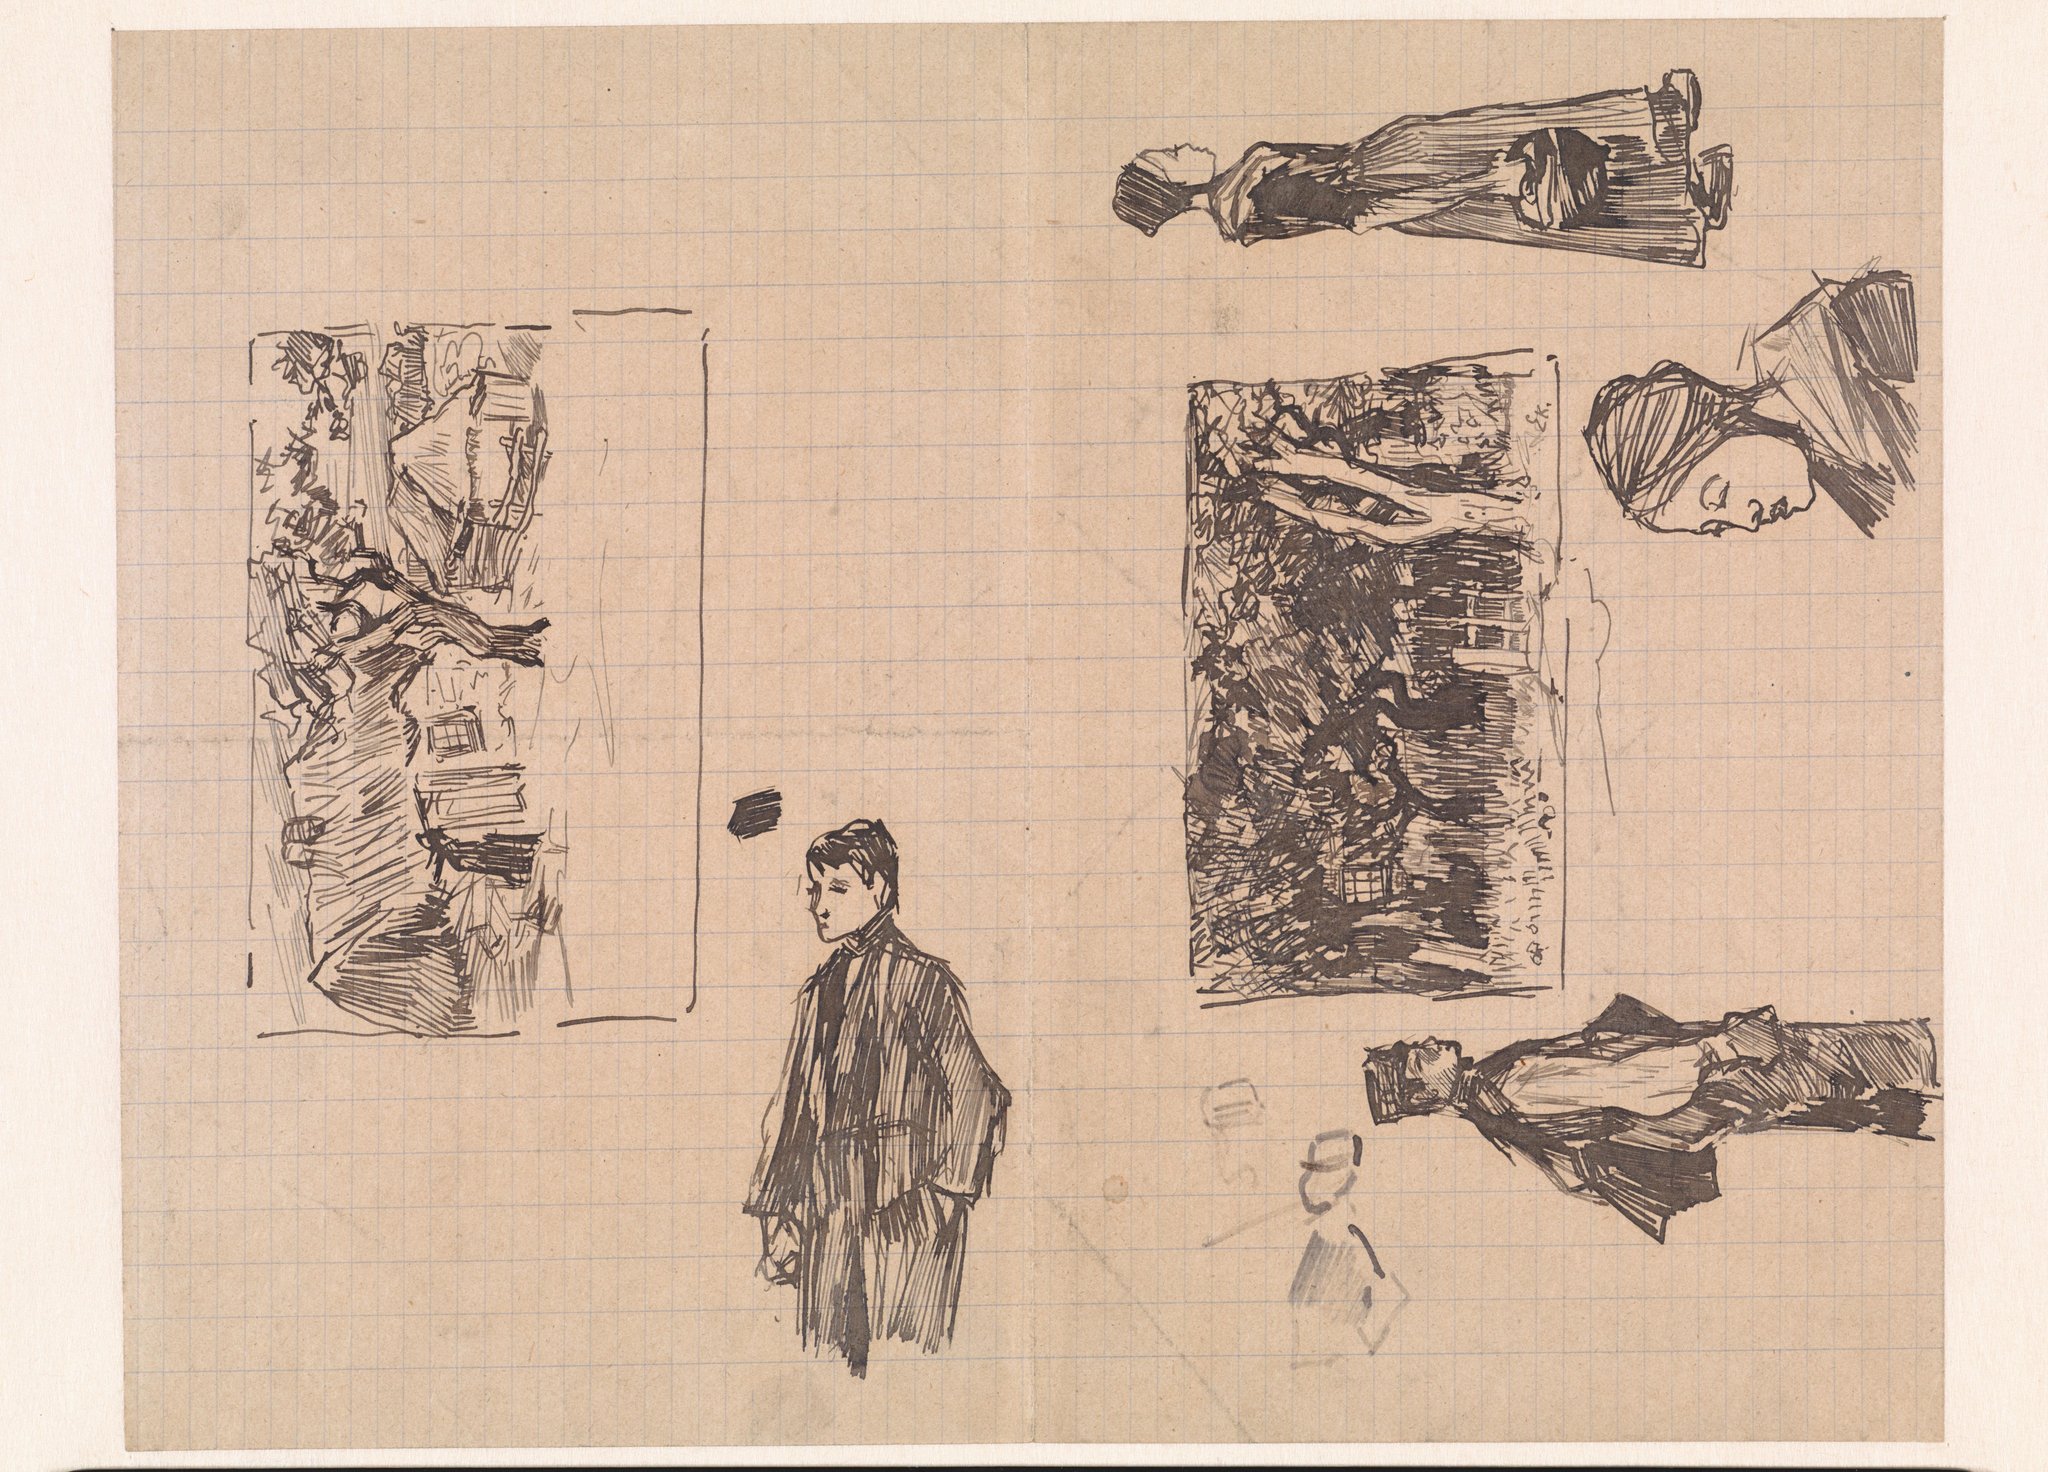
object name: drawing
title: Schetsen van boeren en boerderijen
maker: edzard koning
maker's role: draughtsman, print maker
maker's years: 1869-1954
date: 1879-1954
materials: ink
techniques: pen